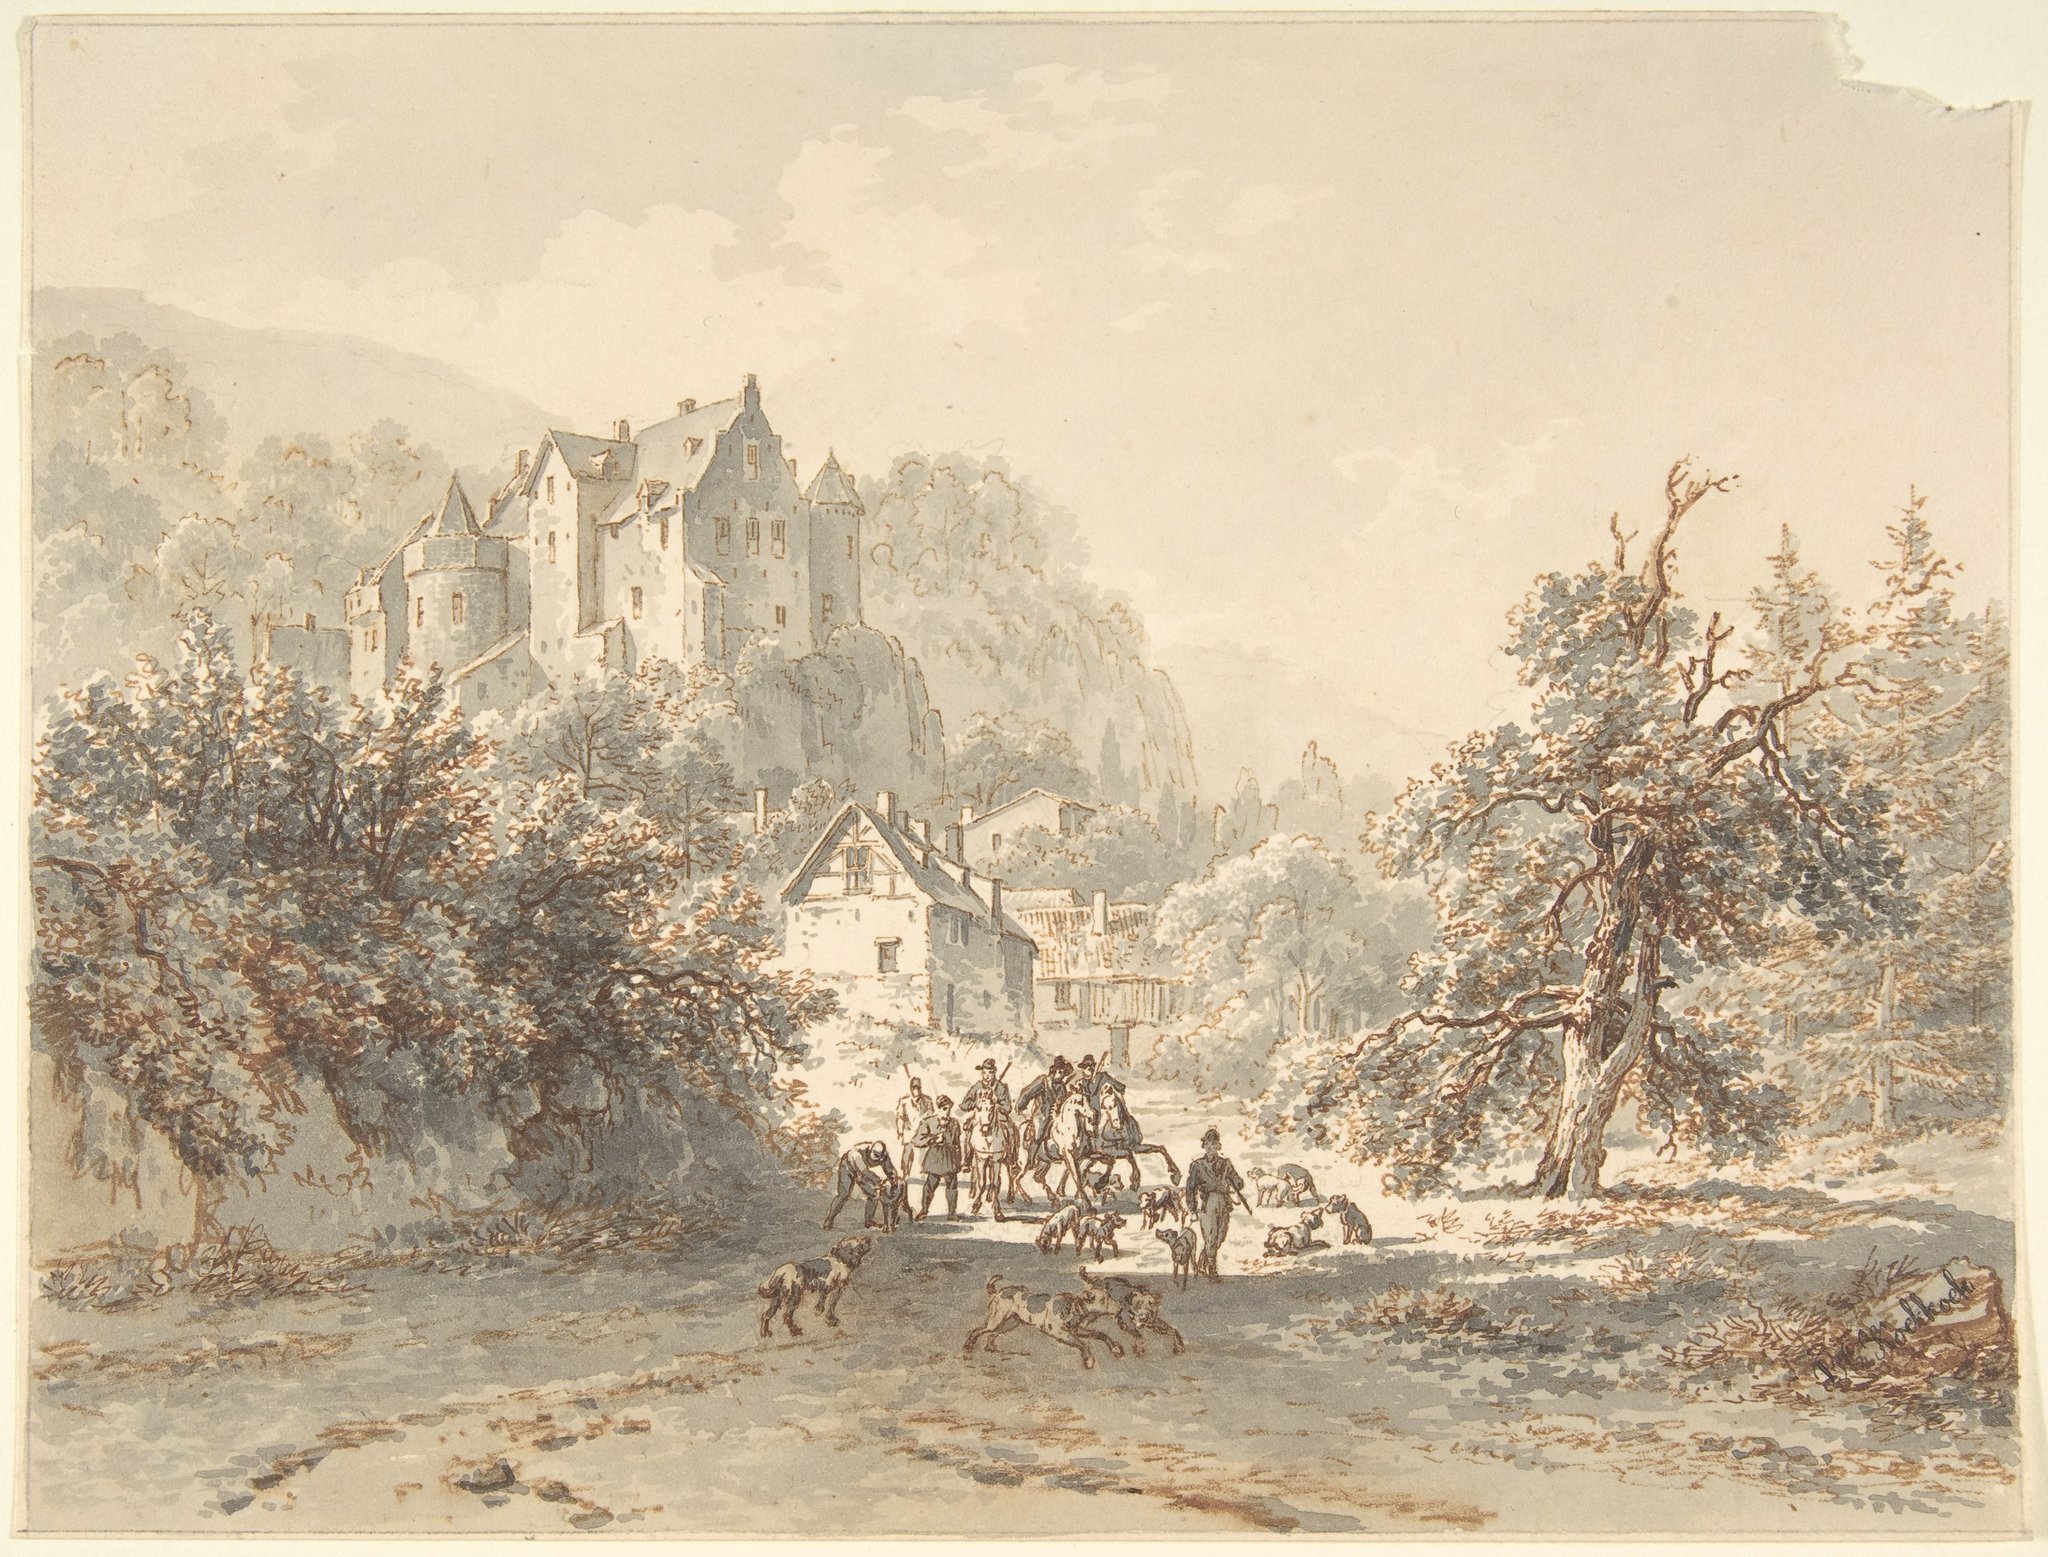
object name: drawing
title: Landscape with a Hunting Party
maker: barend cornelis koekkoek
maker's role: artist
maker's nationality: dutch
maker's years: 1803-1862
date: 1801-1900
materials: graphite, ink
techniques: brush, pen, wash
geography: germany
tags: men,party,hunting,horses,landscapes